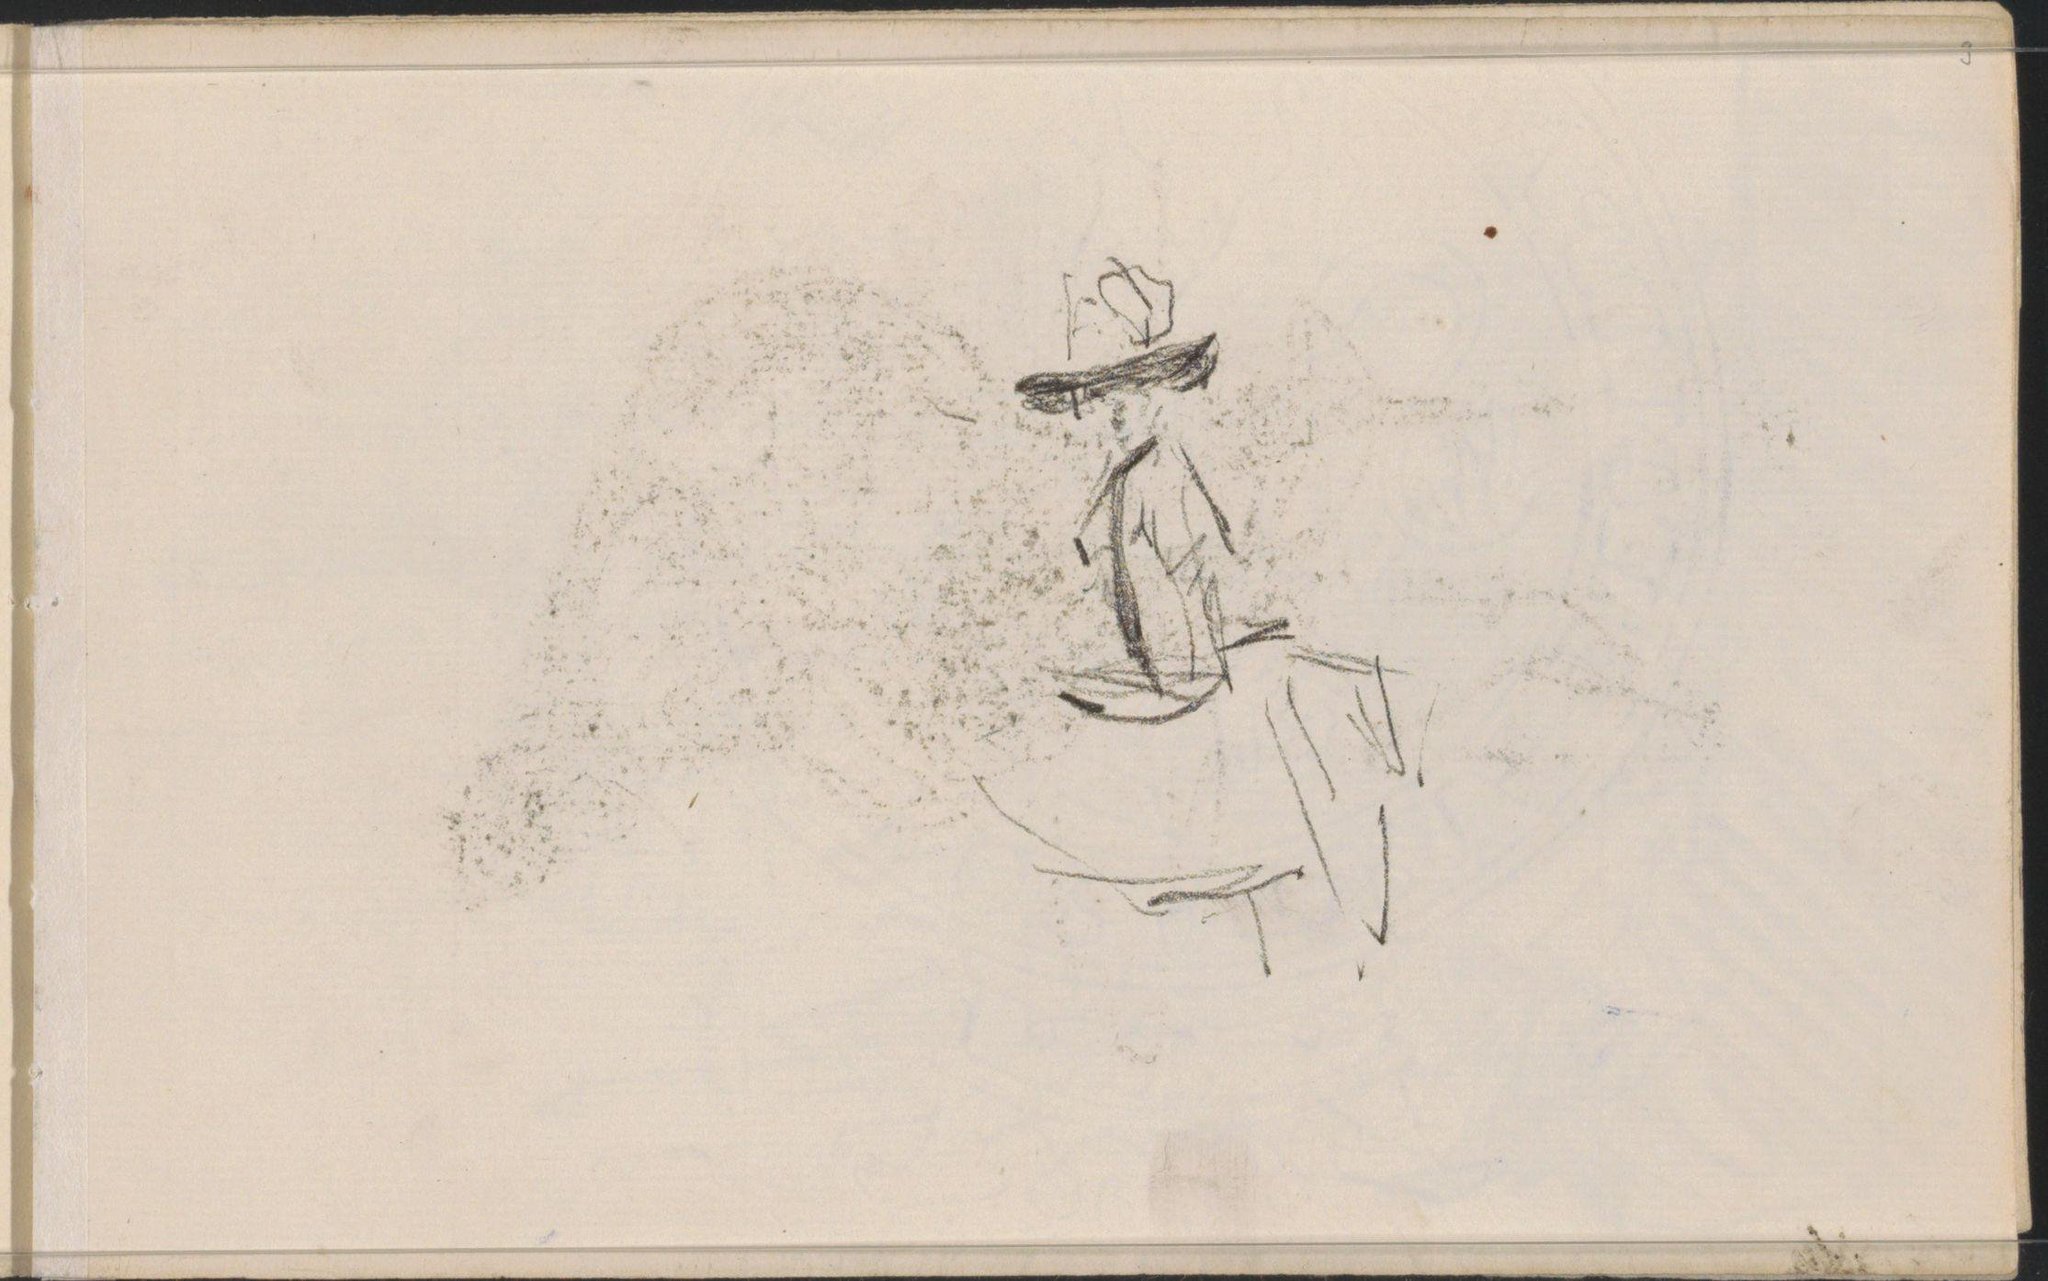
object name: sketchbook leaf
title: Zittende vrouw met hoed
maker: marius bauer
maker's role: draughtsman, print maker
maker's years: 1867-1932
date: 1877-1885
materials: chalk, paper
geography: scheveningen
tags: sitting figure, adult woman, head-gear: hat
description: Pagina 9 uit een schetsboek met 8 bladen.